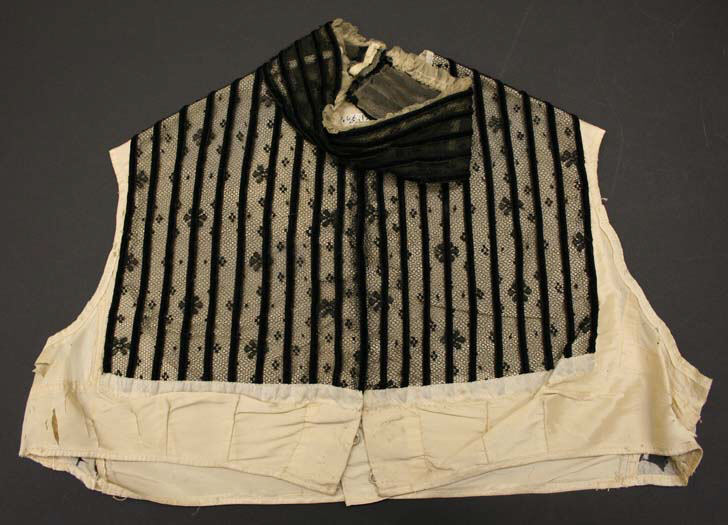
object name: dickey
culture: american or european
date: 1895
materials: silk